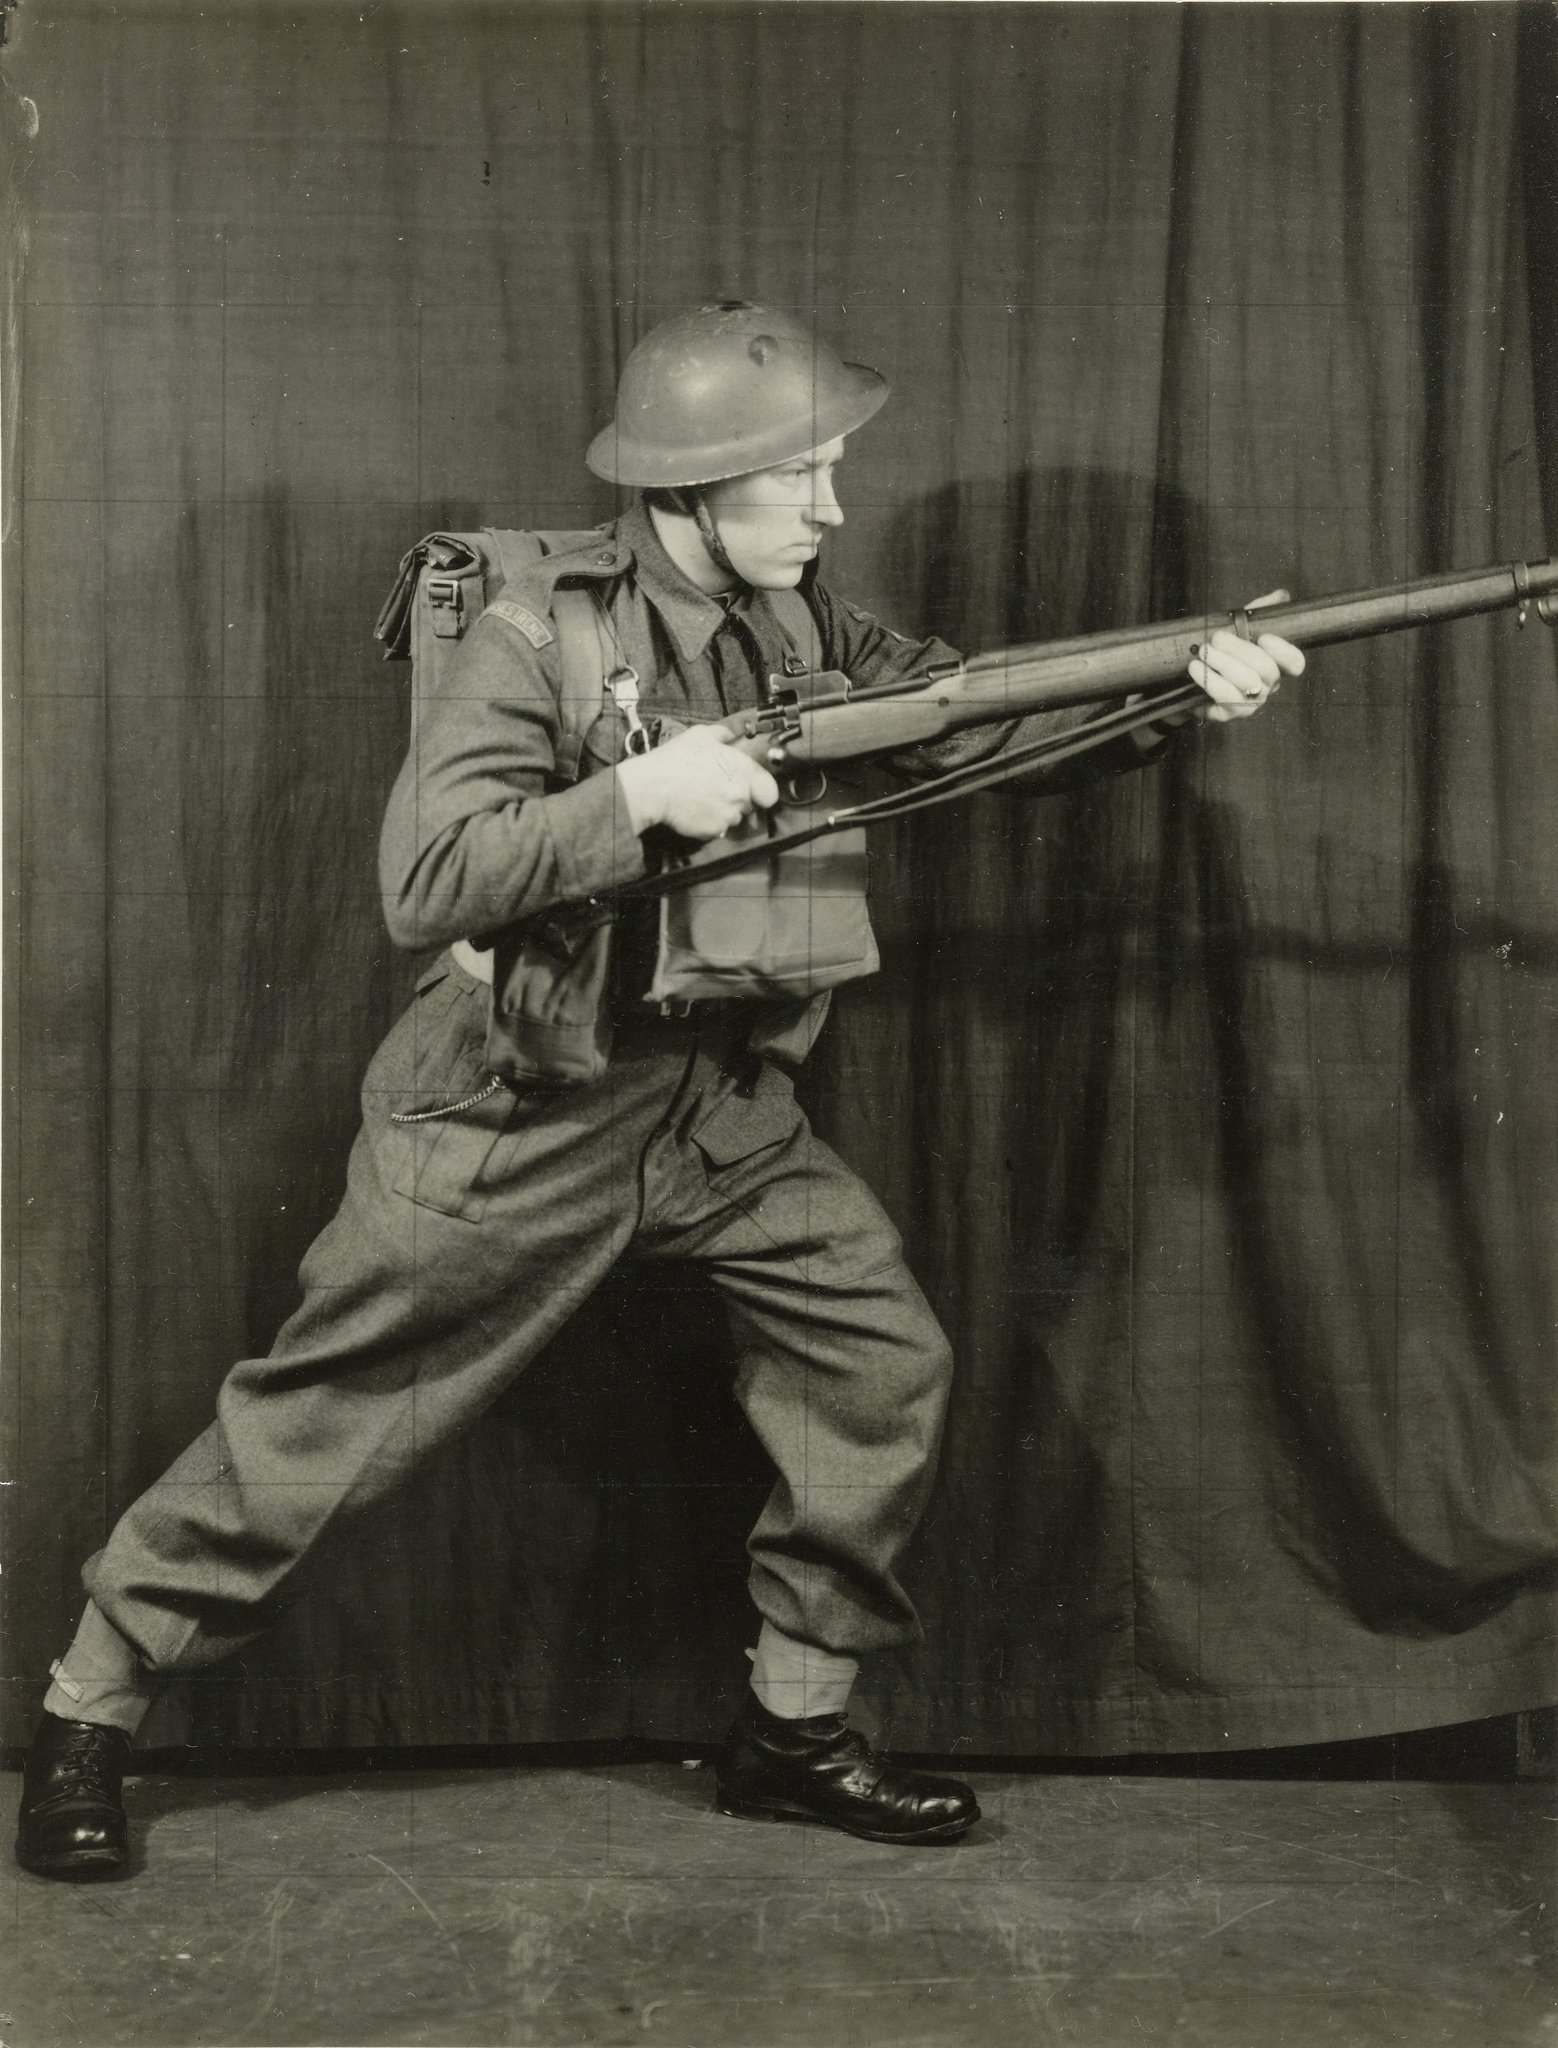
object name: photograph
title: Militair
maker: a.c. cooper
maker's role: fotograaf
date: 1940-1945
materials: photographic support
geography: london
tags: london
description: Geposeerde foto van een militair voor een gordijn, ten voeten uit. Hij richt zijn karabijn. Cor Visser wilde deze foto waarschijnlijk gebruiken voor een van zijn tekeningen, vandaar het lijnennet dat hij op de foto getekend heeft.